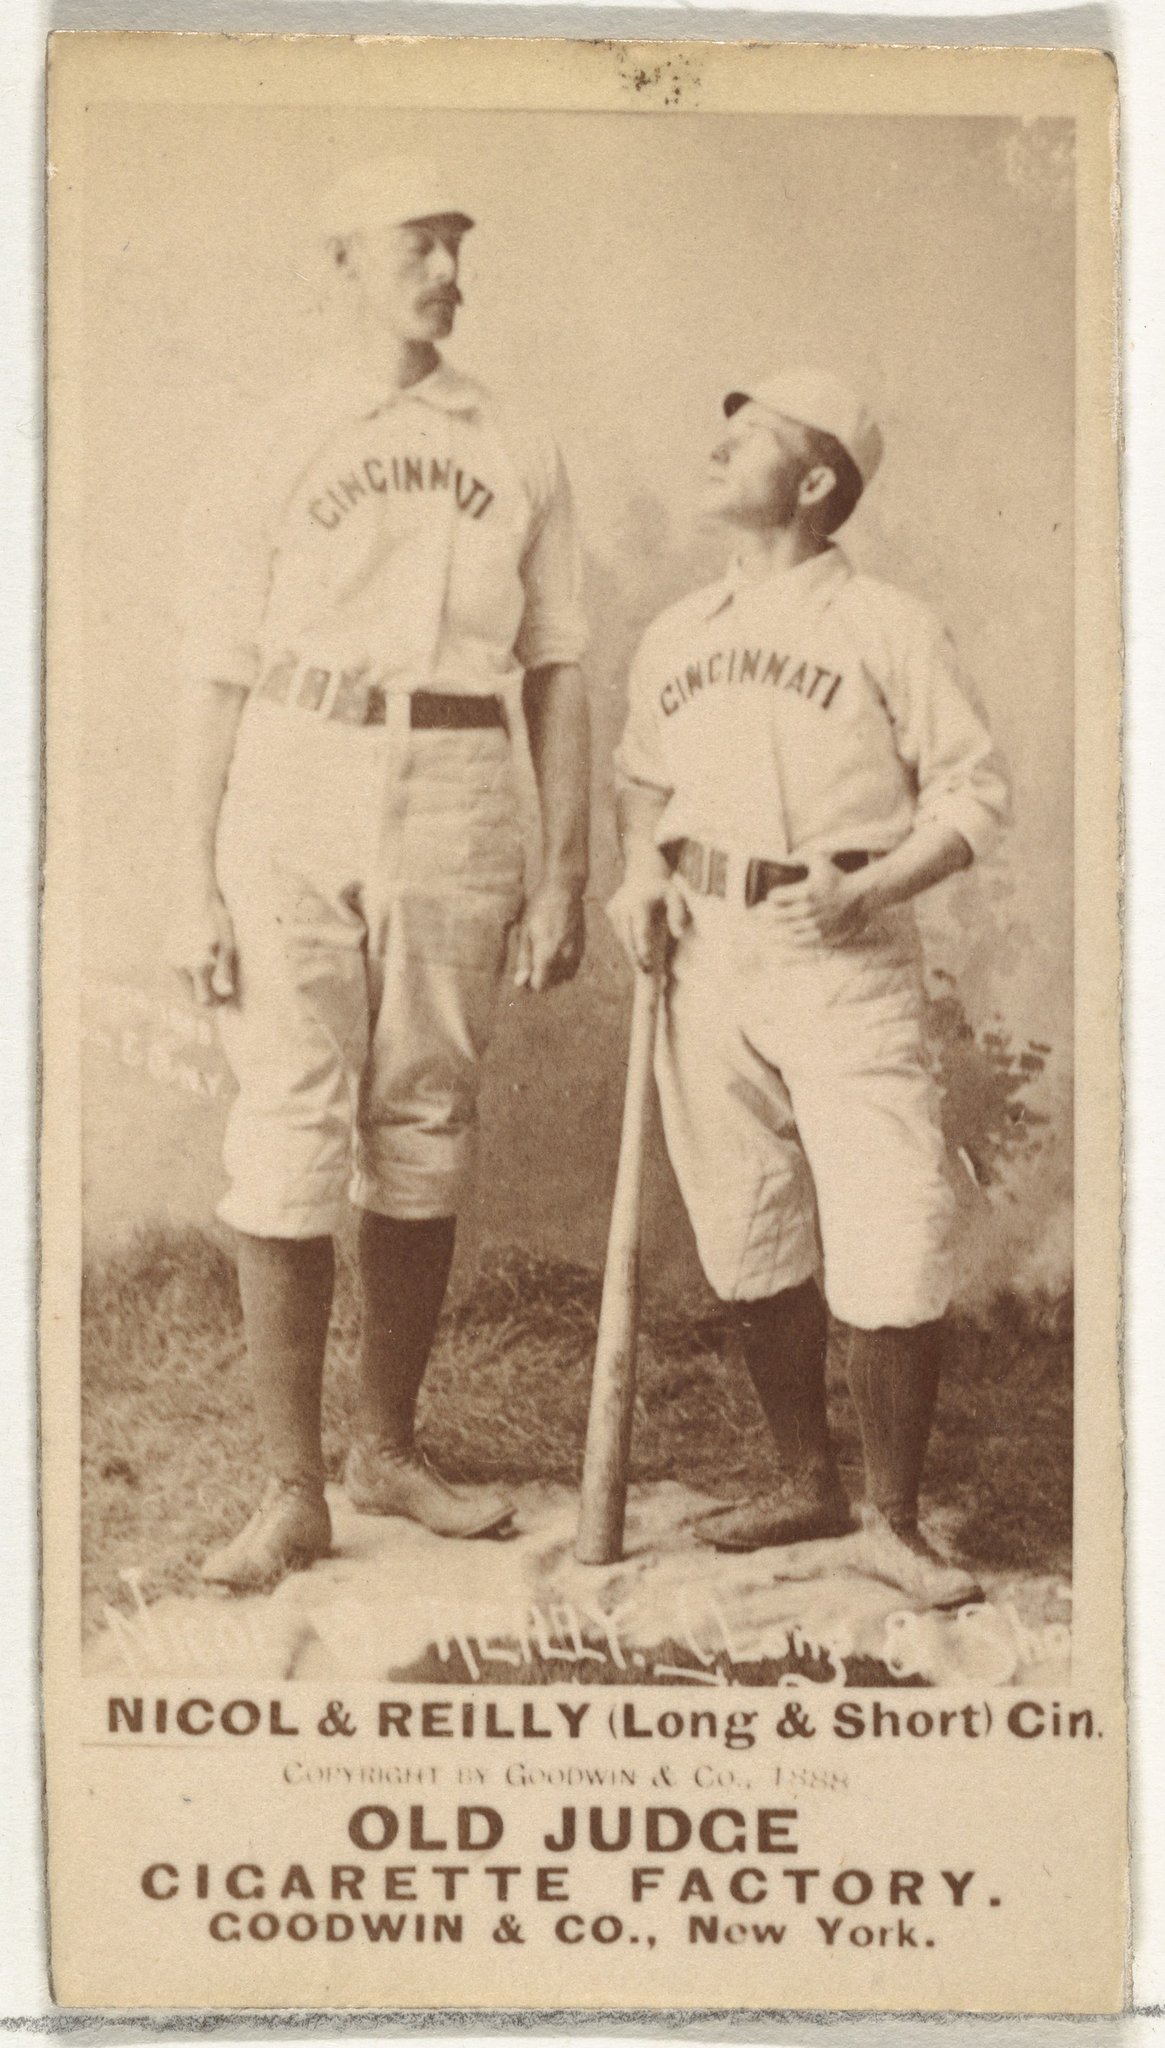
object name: baseball card, photograph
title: Hugh N. "Little Nick" Nicol and John Good "Long John" Reilly, "Long & Short", Cincinnati, from the Old Judge series (N172) for Old Judge Cigarettes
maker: goodwin & company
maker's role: publisher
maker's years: 1850-1950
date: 1888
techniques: albumen silver print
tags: men,portraits,baseball,athletes